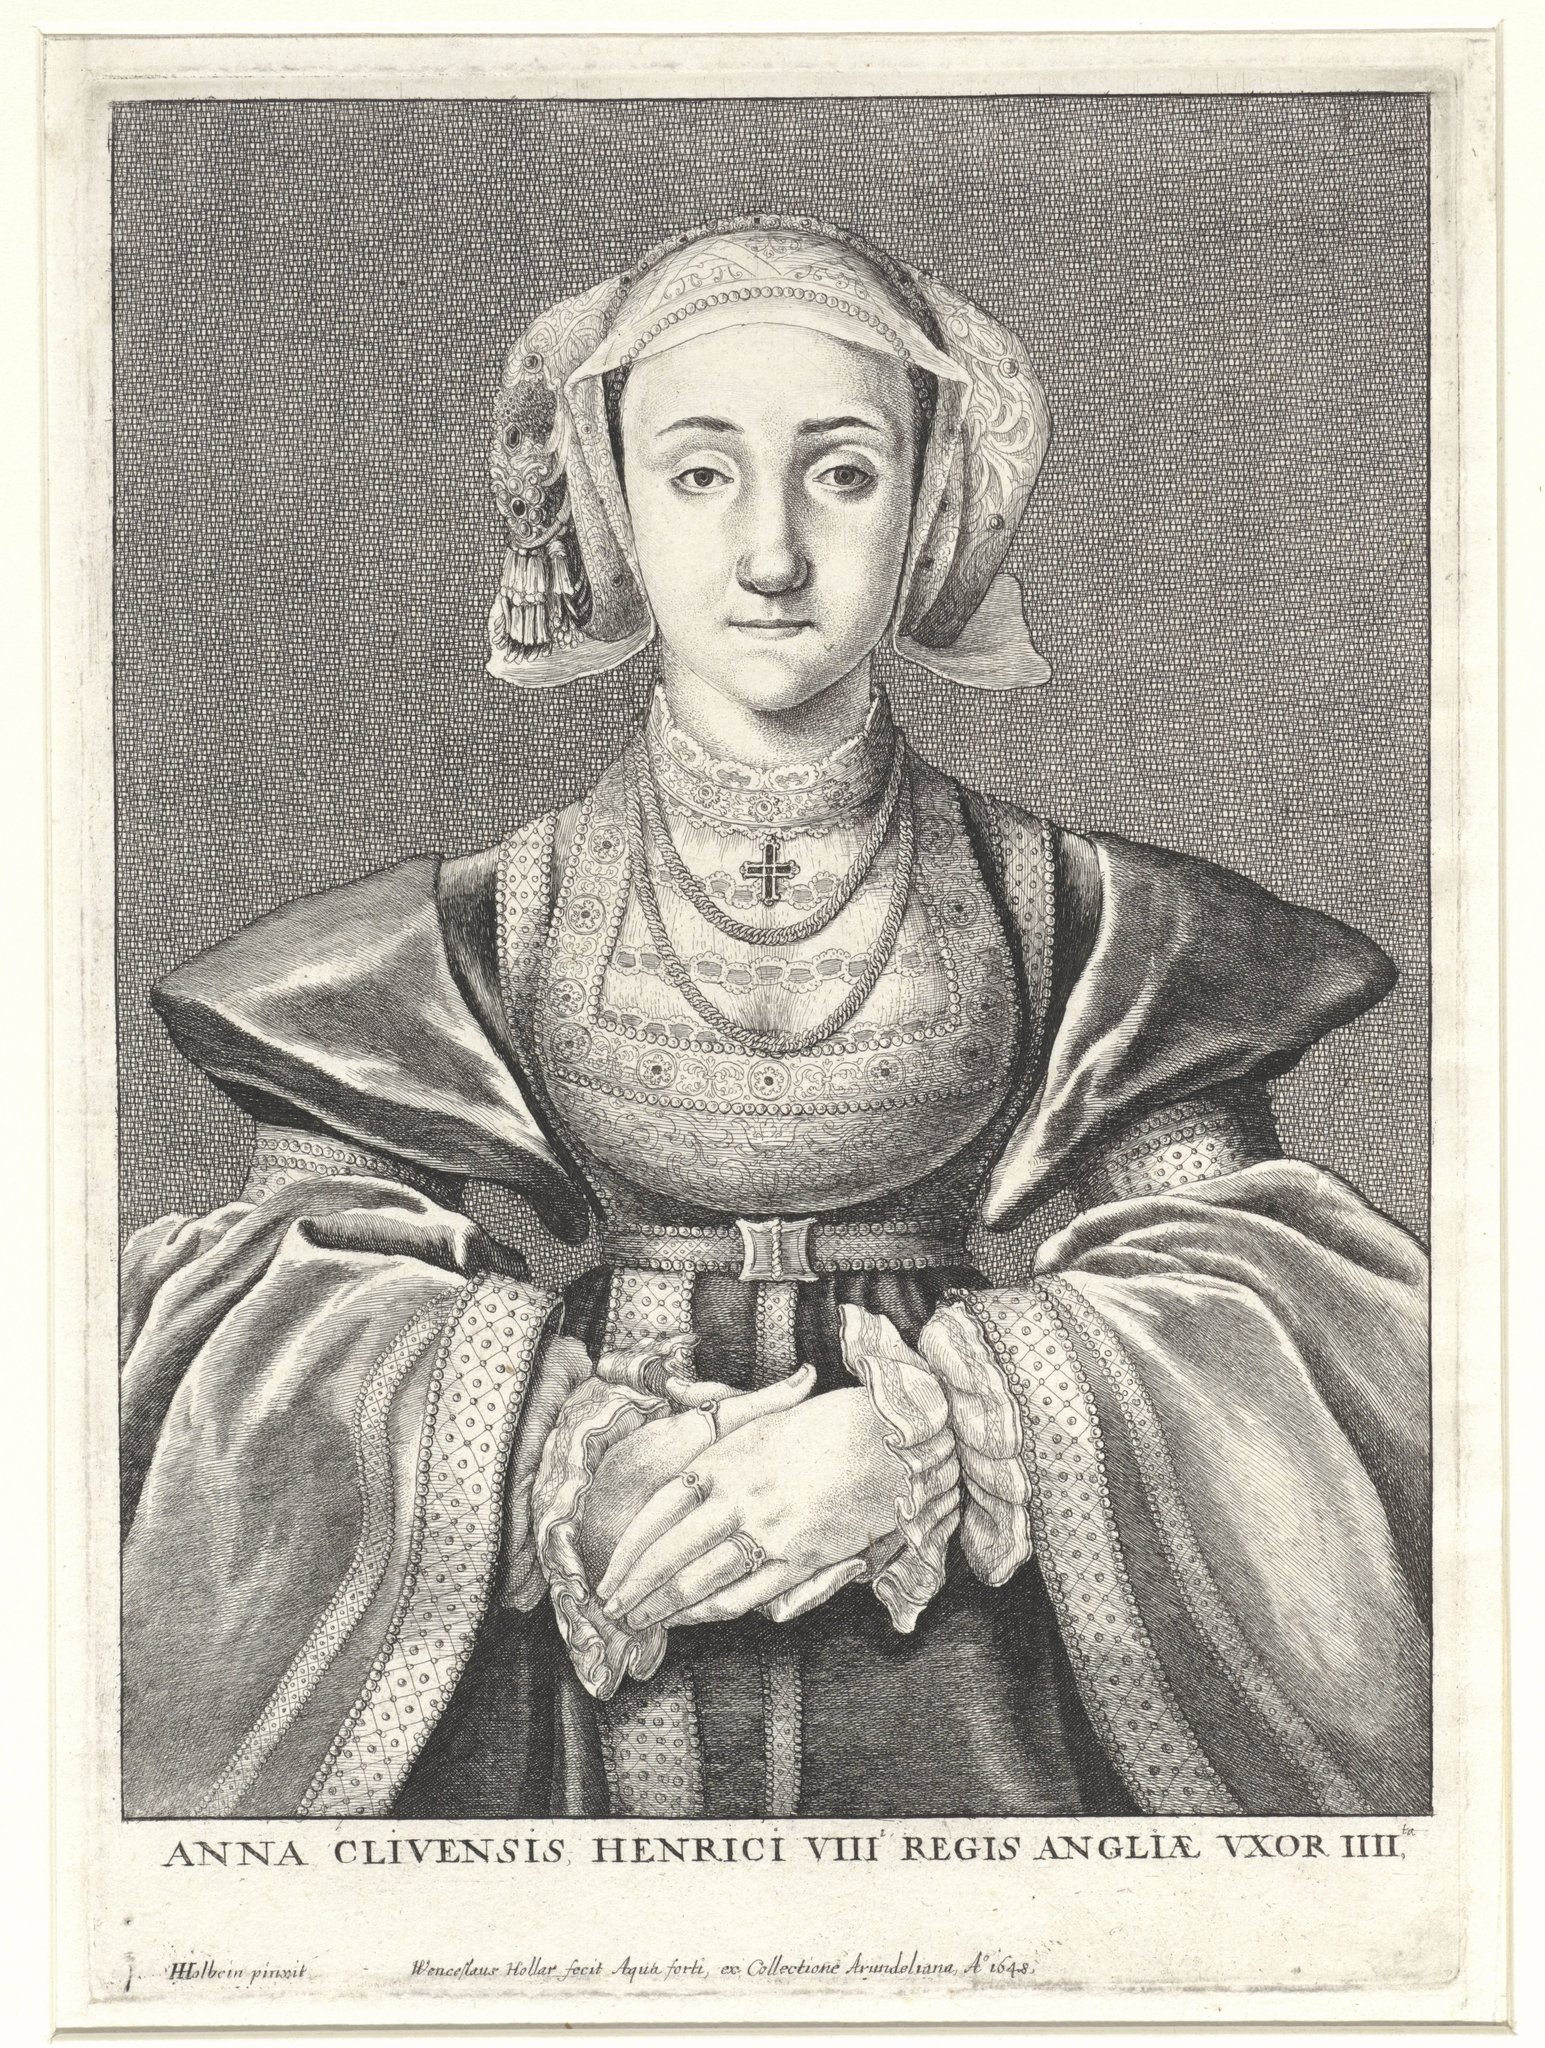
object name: print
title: Portret van Anna van Kleef, koningin van Engeland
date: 1649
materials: paper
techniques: etching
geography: antwerp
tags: head-gear: cap (+ women's clothes)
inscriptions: collector's mark: Lugt 240